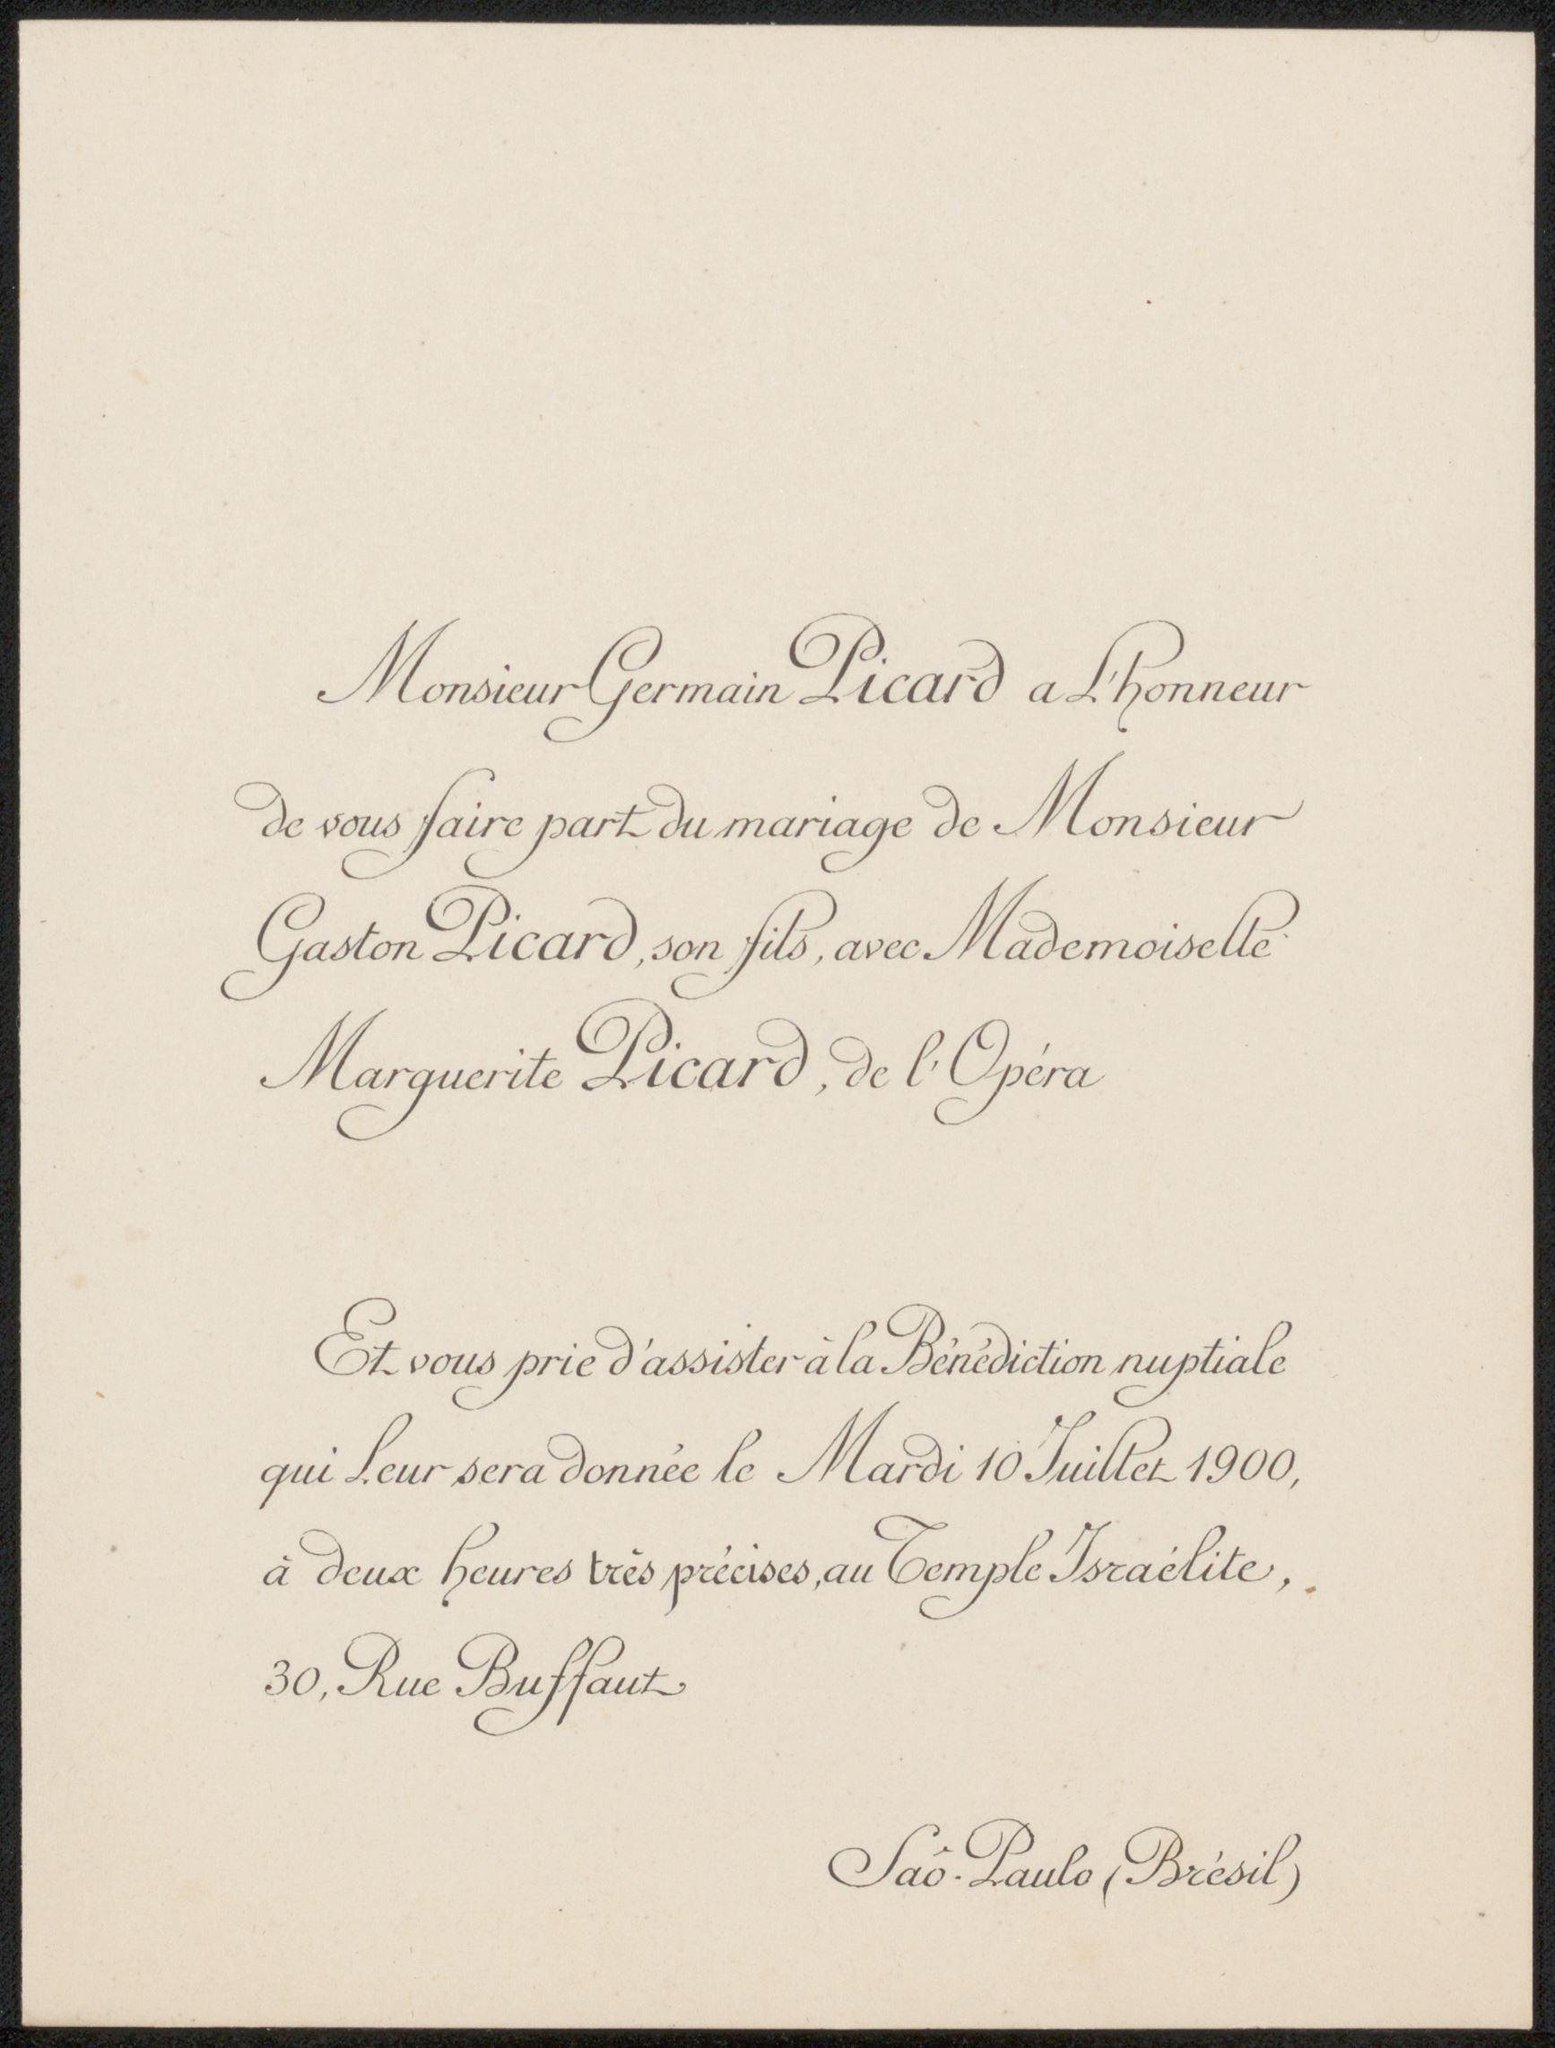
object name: wedding announcement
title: Huwelijksaankondiging aan Philip Zilcken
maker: Anonymous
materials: paper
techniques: printing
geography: sao paulo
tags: marguerite picard, the hague, painter, draughtsman, philip zilcken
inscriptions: collector's mark: ‘RPK’